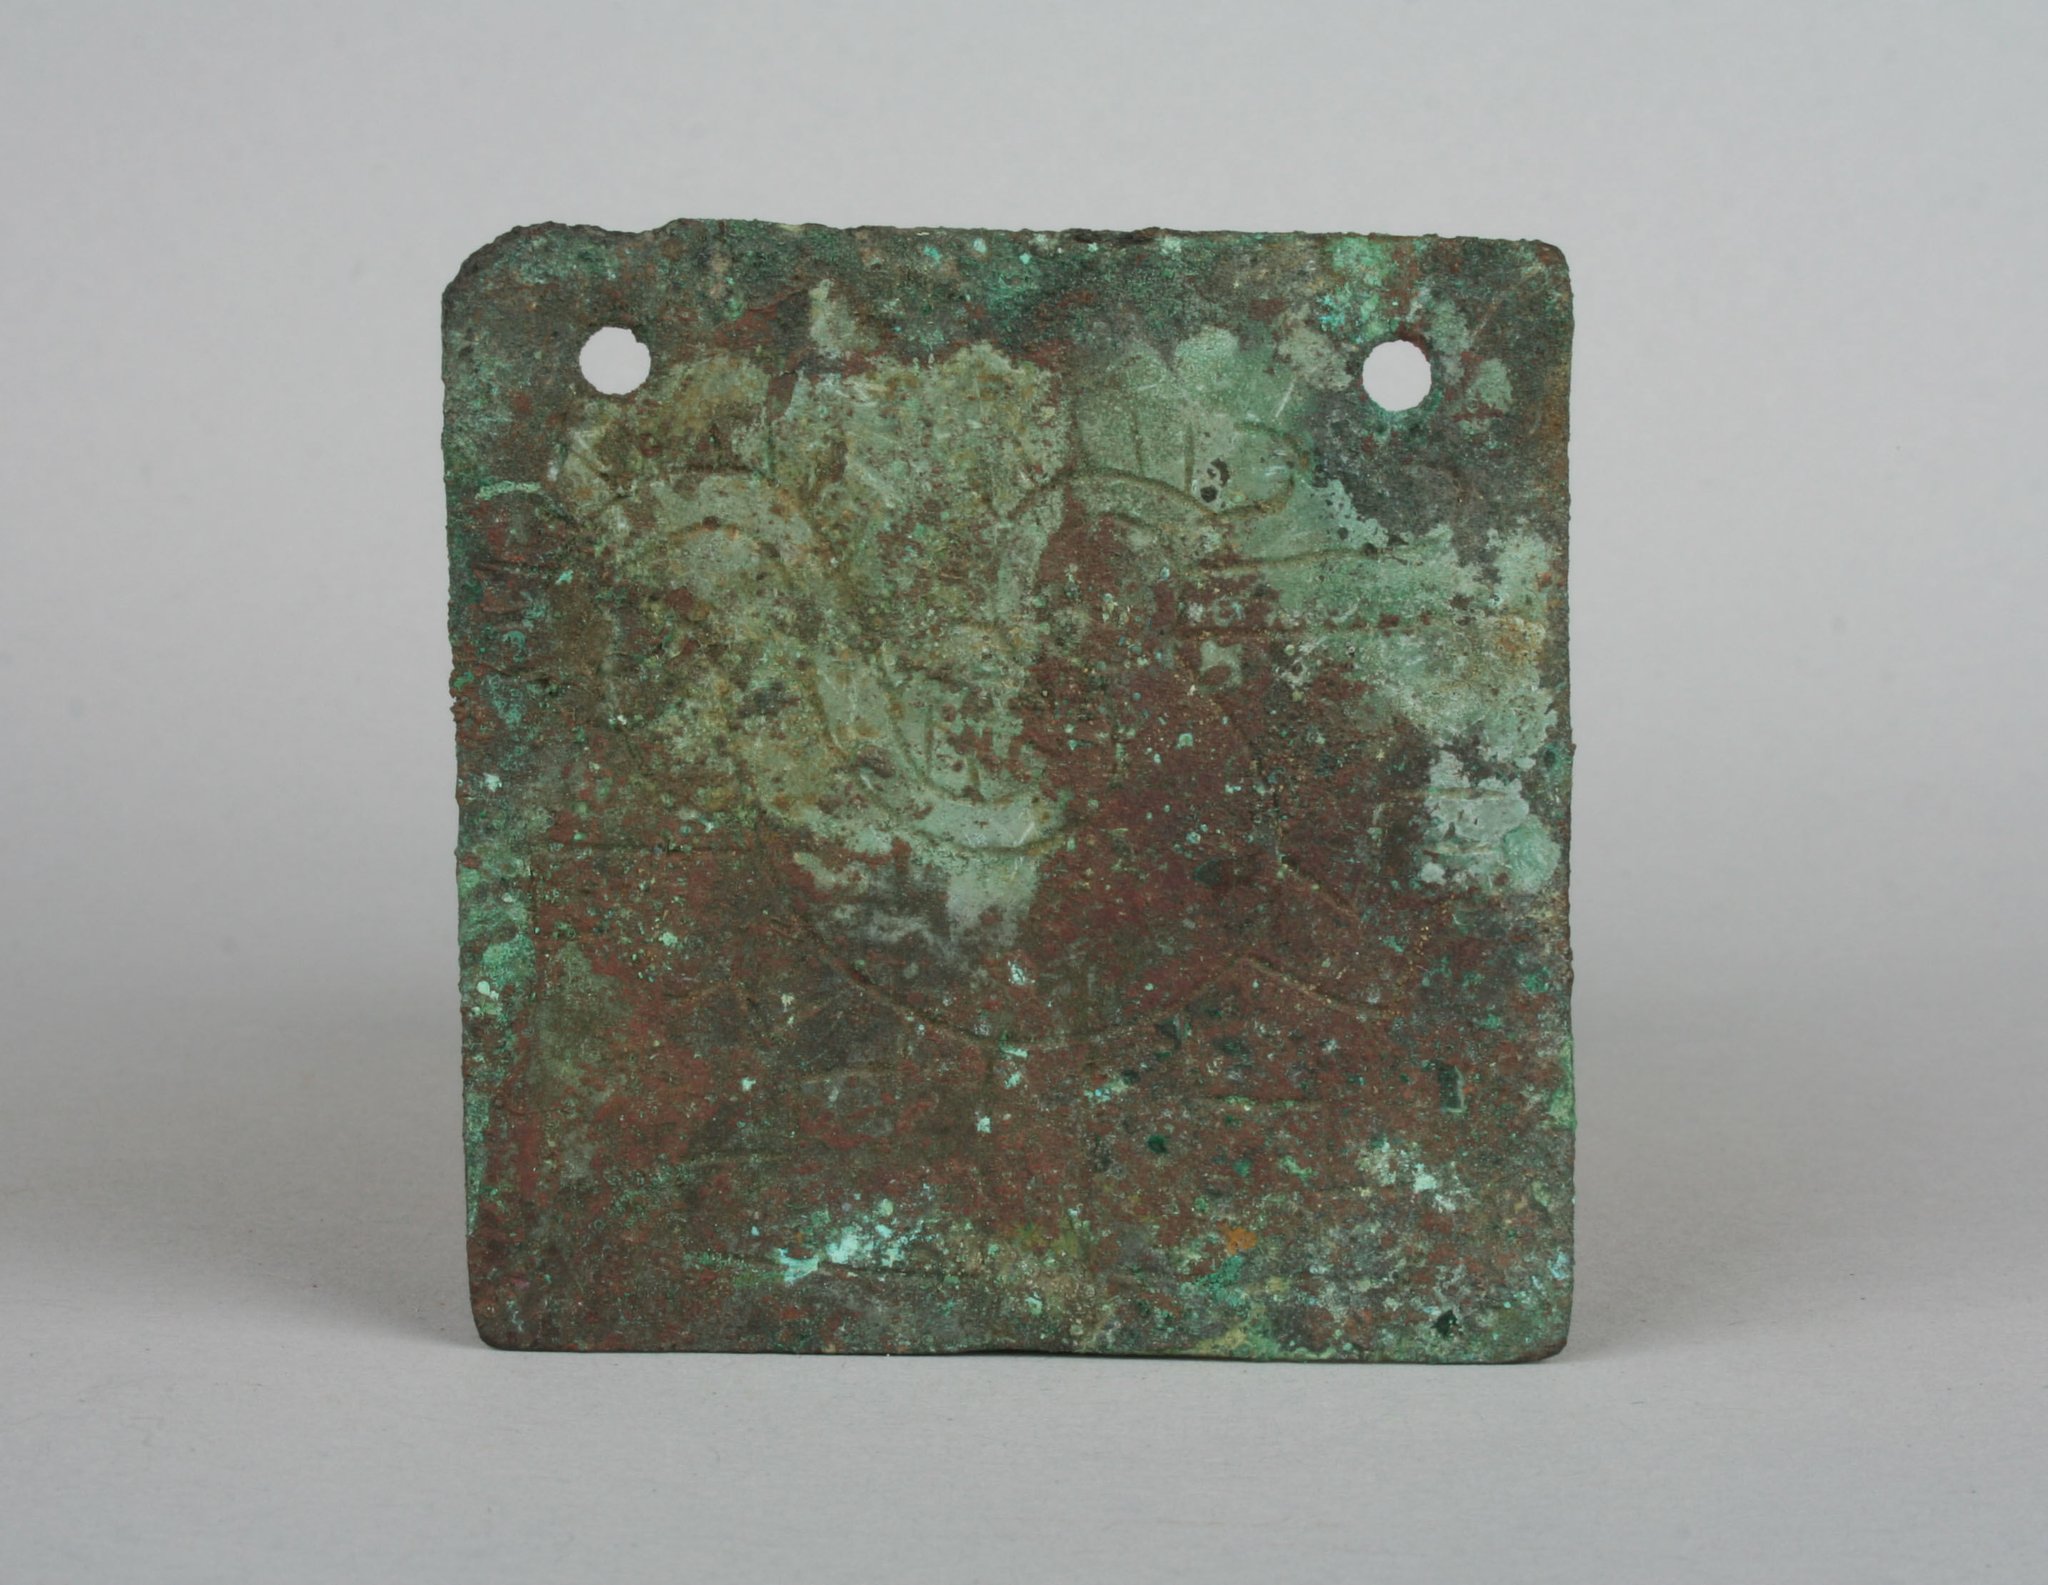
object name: ornament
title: Bird Plaque Ornament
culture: vicús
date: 300 BCE-200 CE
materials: copper, gilt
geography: peru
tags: birds